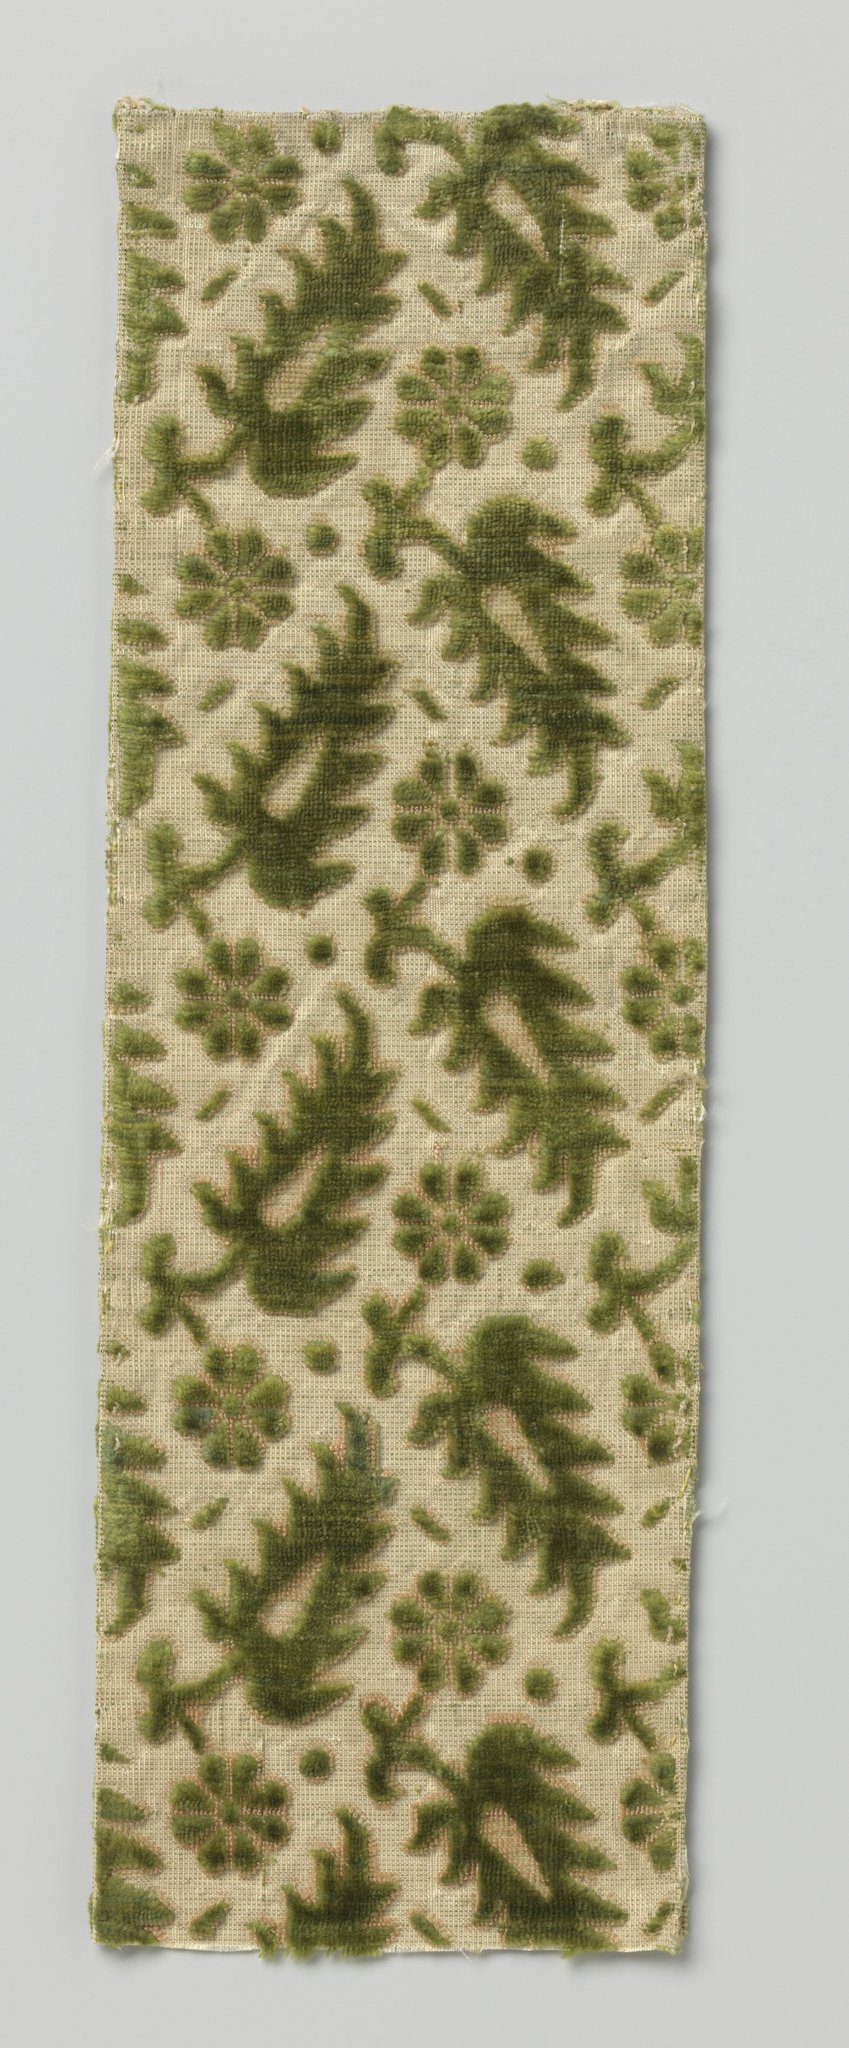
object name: zijdefluweel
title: Fragment ciseléfluweel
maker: Anonymous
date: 1550-1650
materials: ciselé velvet, silk, velvet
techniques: weave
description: Een fragment van een geciseleerd fluweel, gedecoreerd met gestrooide bladen en bloemen in groen. Het dessin is omringd door een zalmkleurige inslag. Opmerking: Zelfkant; 1 cm, effenbinding, 1 cm omgevouwen aan boven- en onderzijde.